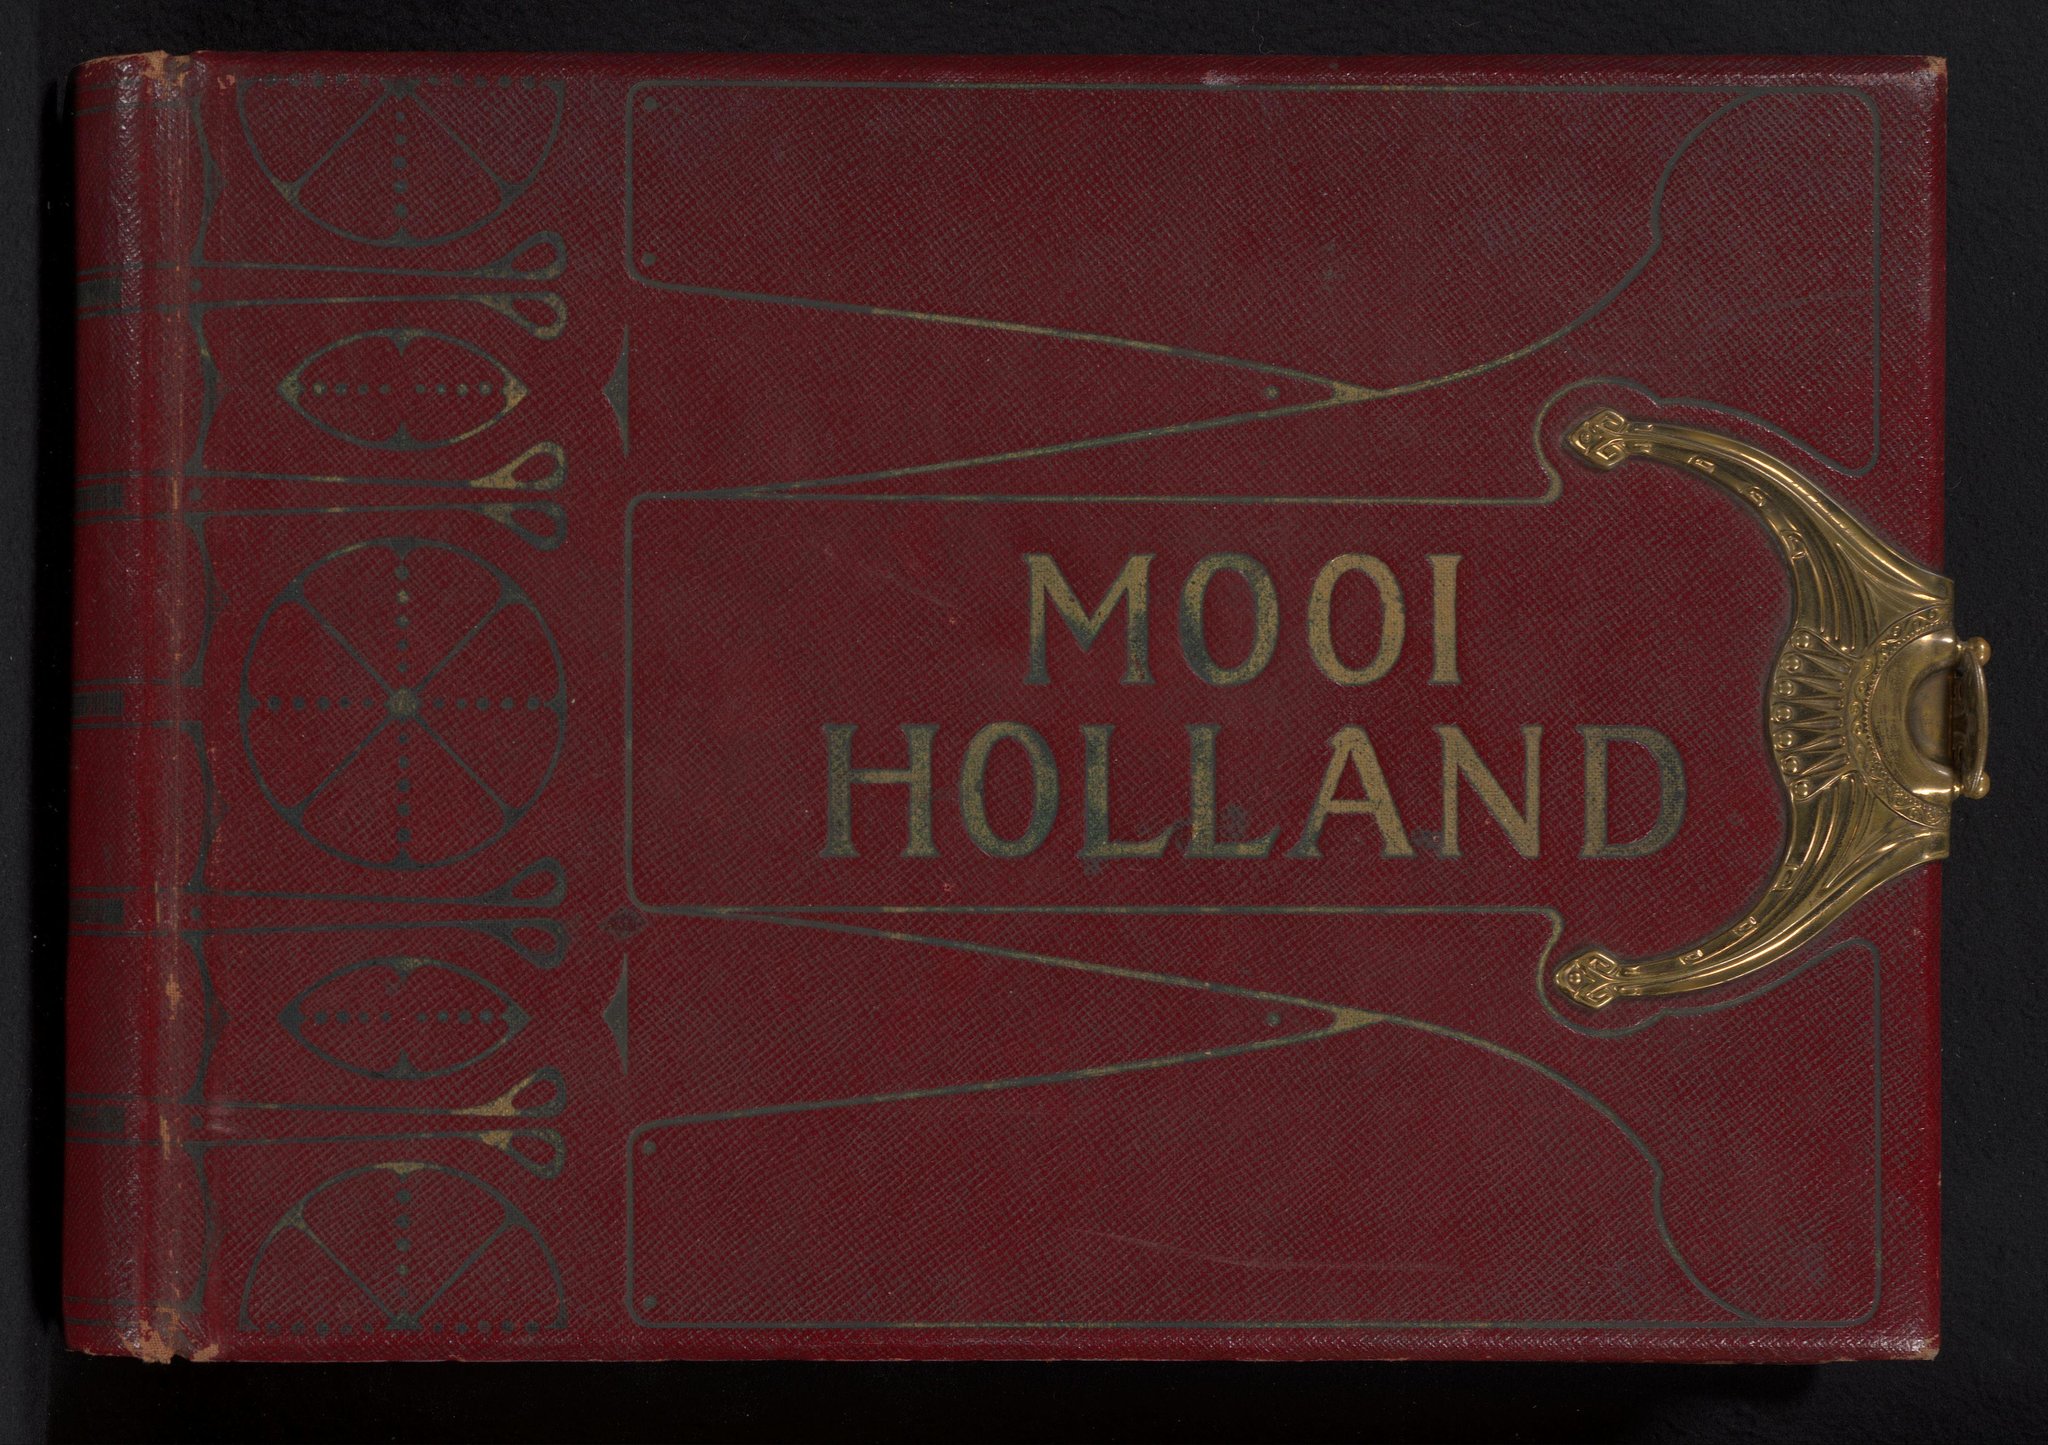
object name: photograph album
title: Mooi Holland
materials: cardboard, leather, metal, paper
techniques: photograph, decorated paper, photoaquatint, printing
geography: netherlands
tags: square, place, circus, etc., church (exterior), civic architecture; edifices; dwellings, street, the hague, haarlem, nijmegen, amsterdam, arnhem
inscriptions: annotation: ‘zeer zeldzaam’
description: Hotelalbum met advertenties en gezichten op Nederlandse plaatsen en gebouwen, 'Uitgave in overleg met den nationalen bond voor vreemdelingenverkeer in Nederland'.